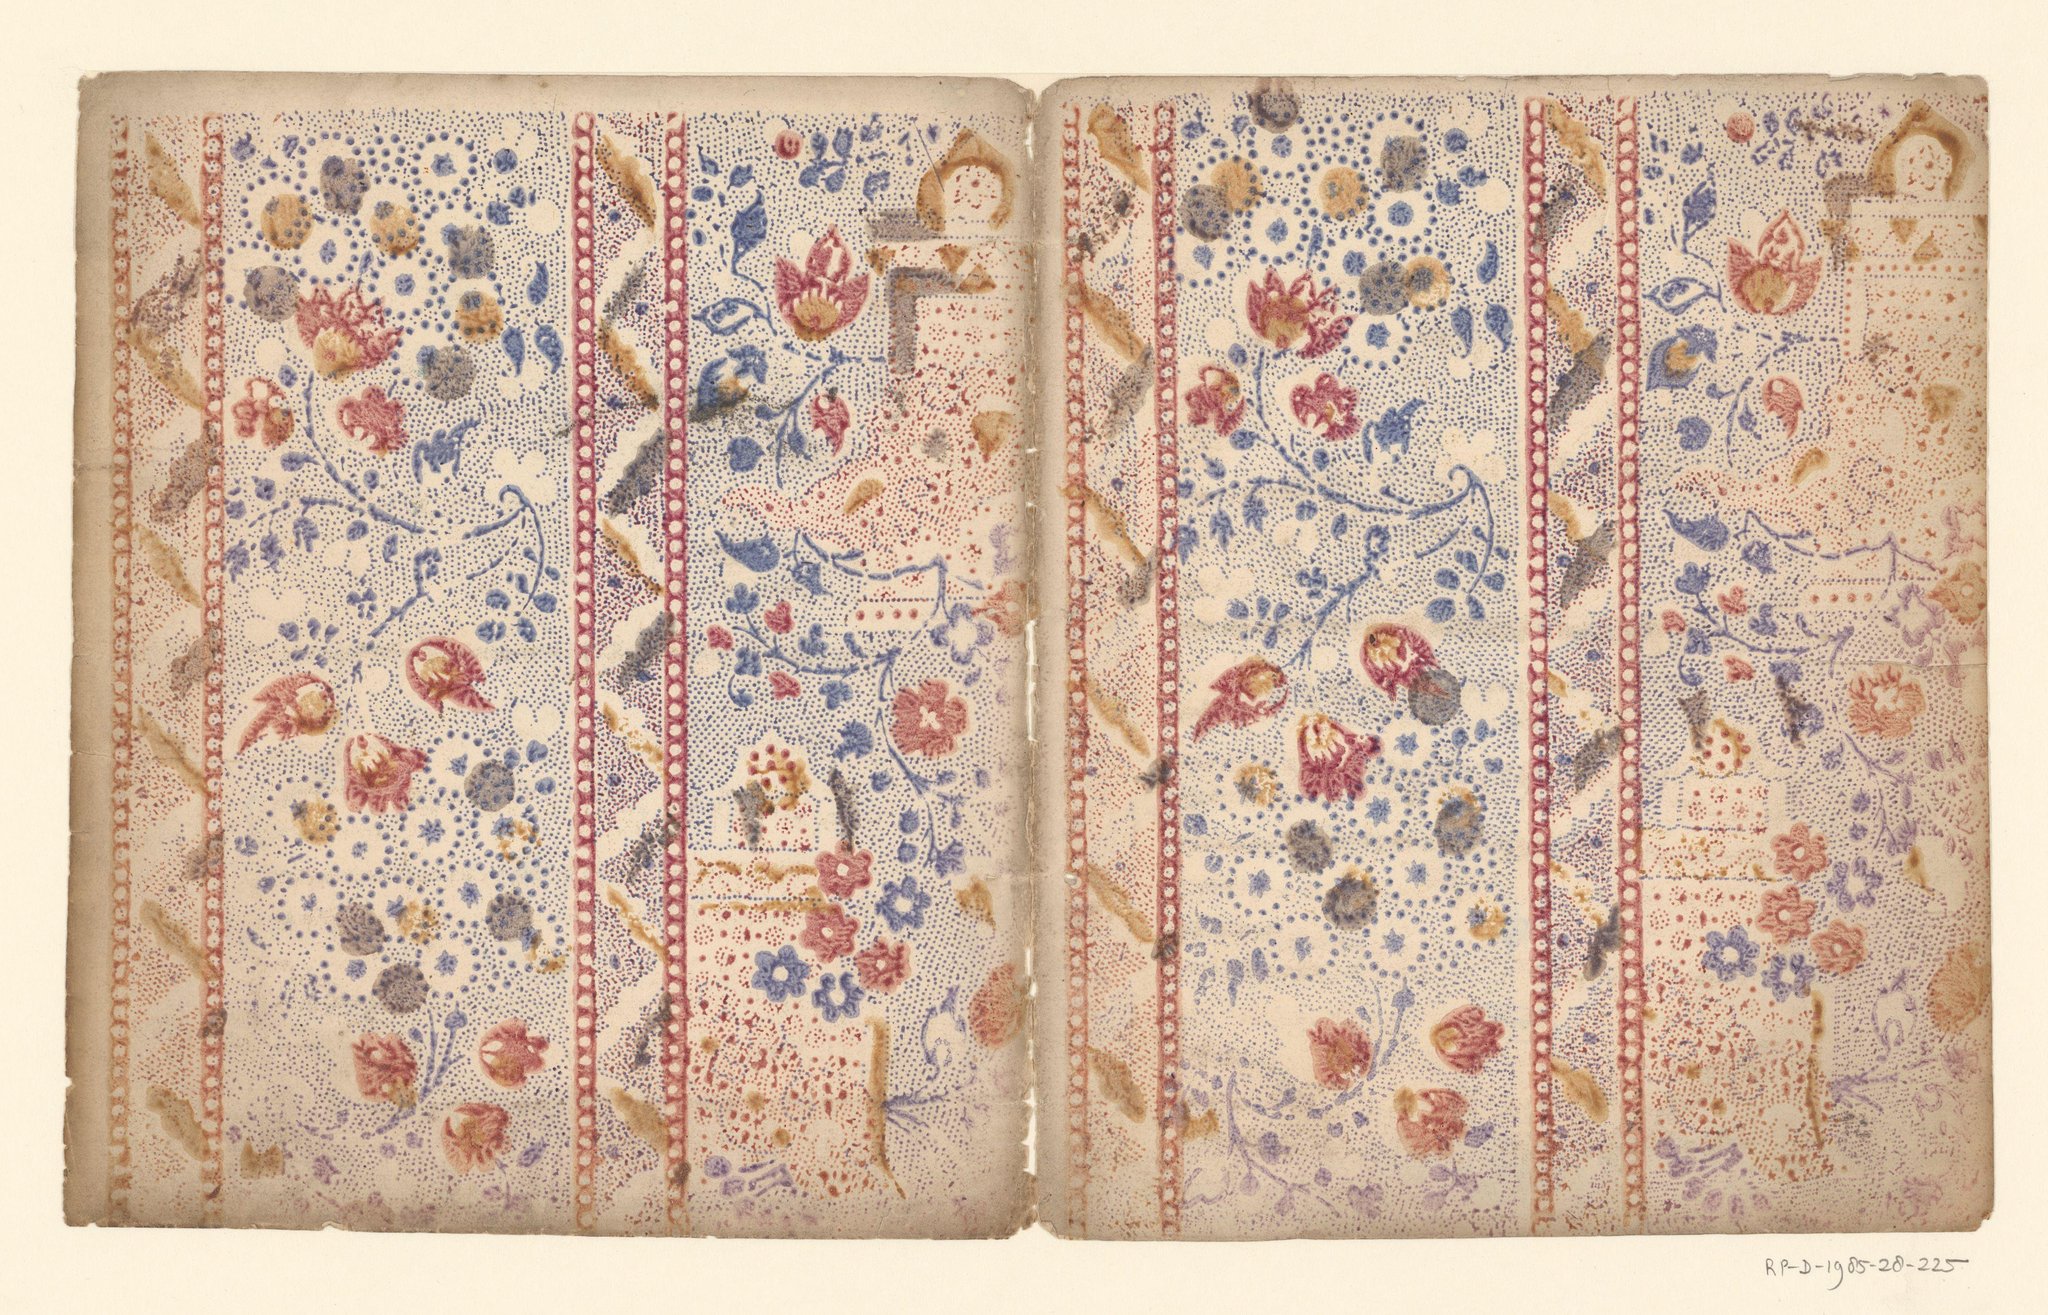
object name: printed paper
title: Twee bladen met banenpatroon met bloemen en vruchten met puntenfond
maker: Anonymous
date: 1750-1900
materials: paper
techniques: printing block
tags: ornament derived from plant forms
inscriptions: collector's mark: Lugt 2228, collector's mark: Lugt 2760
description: Twee bladen met verticaal banenpatroon met bloemen en vruchten met onderbroken puntenfond. Twee losse helften van een omslag.